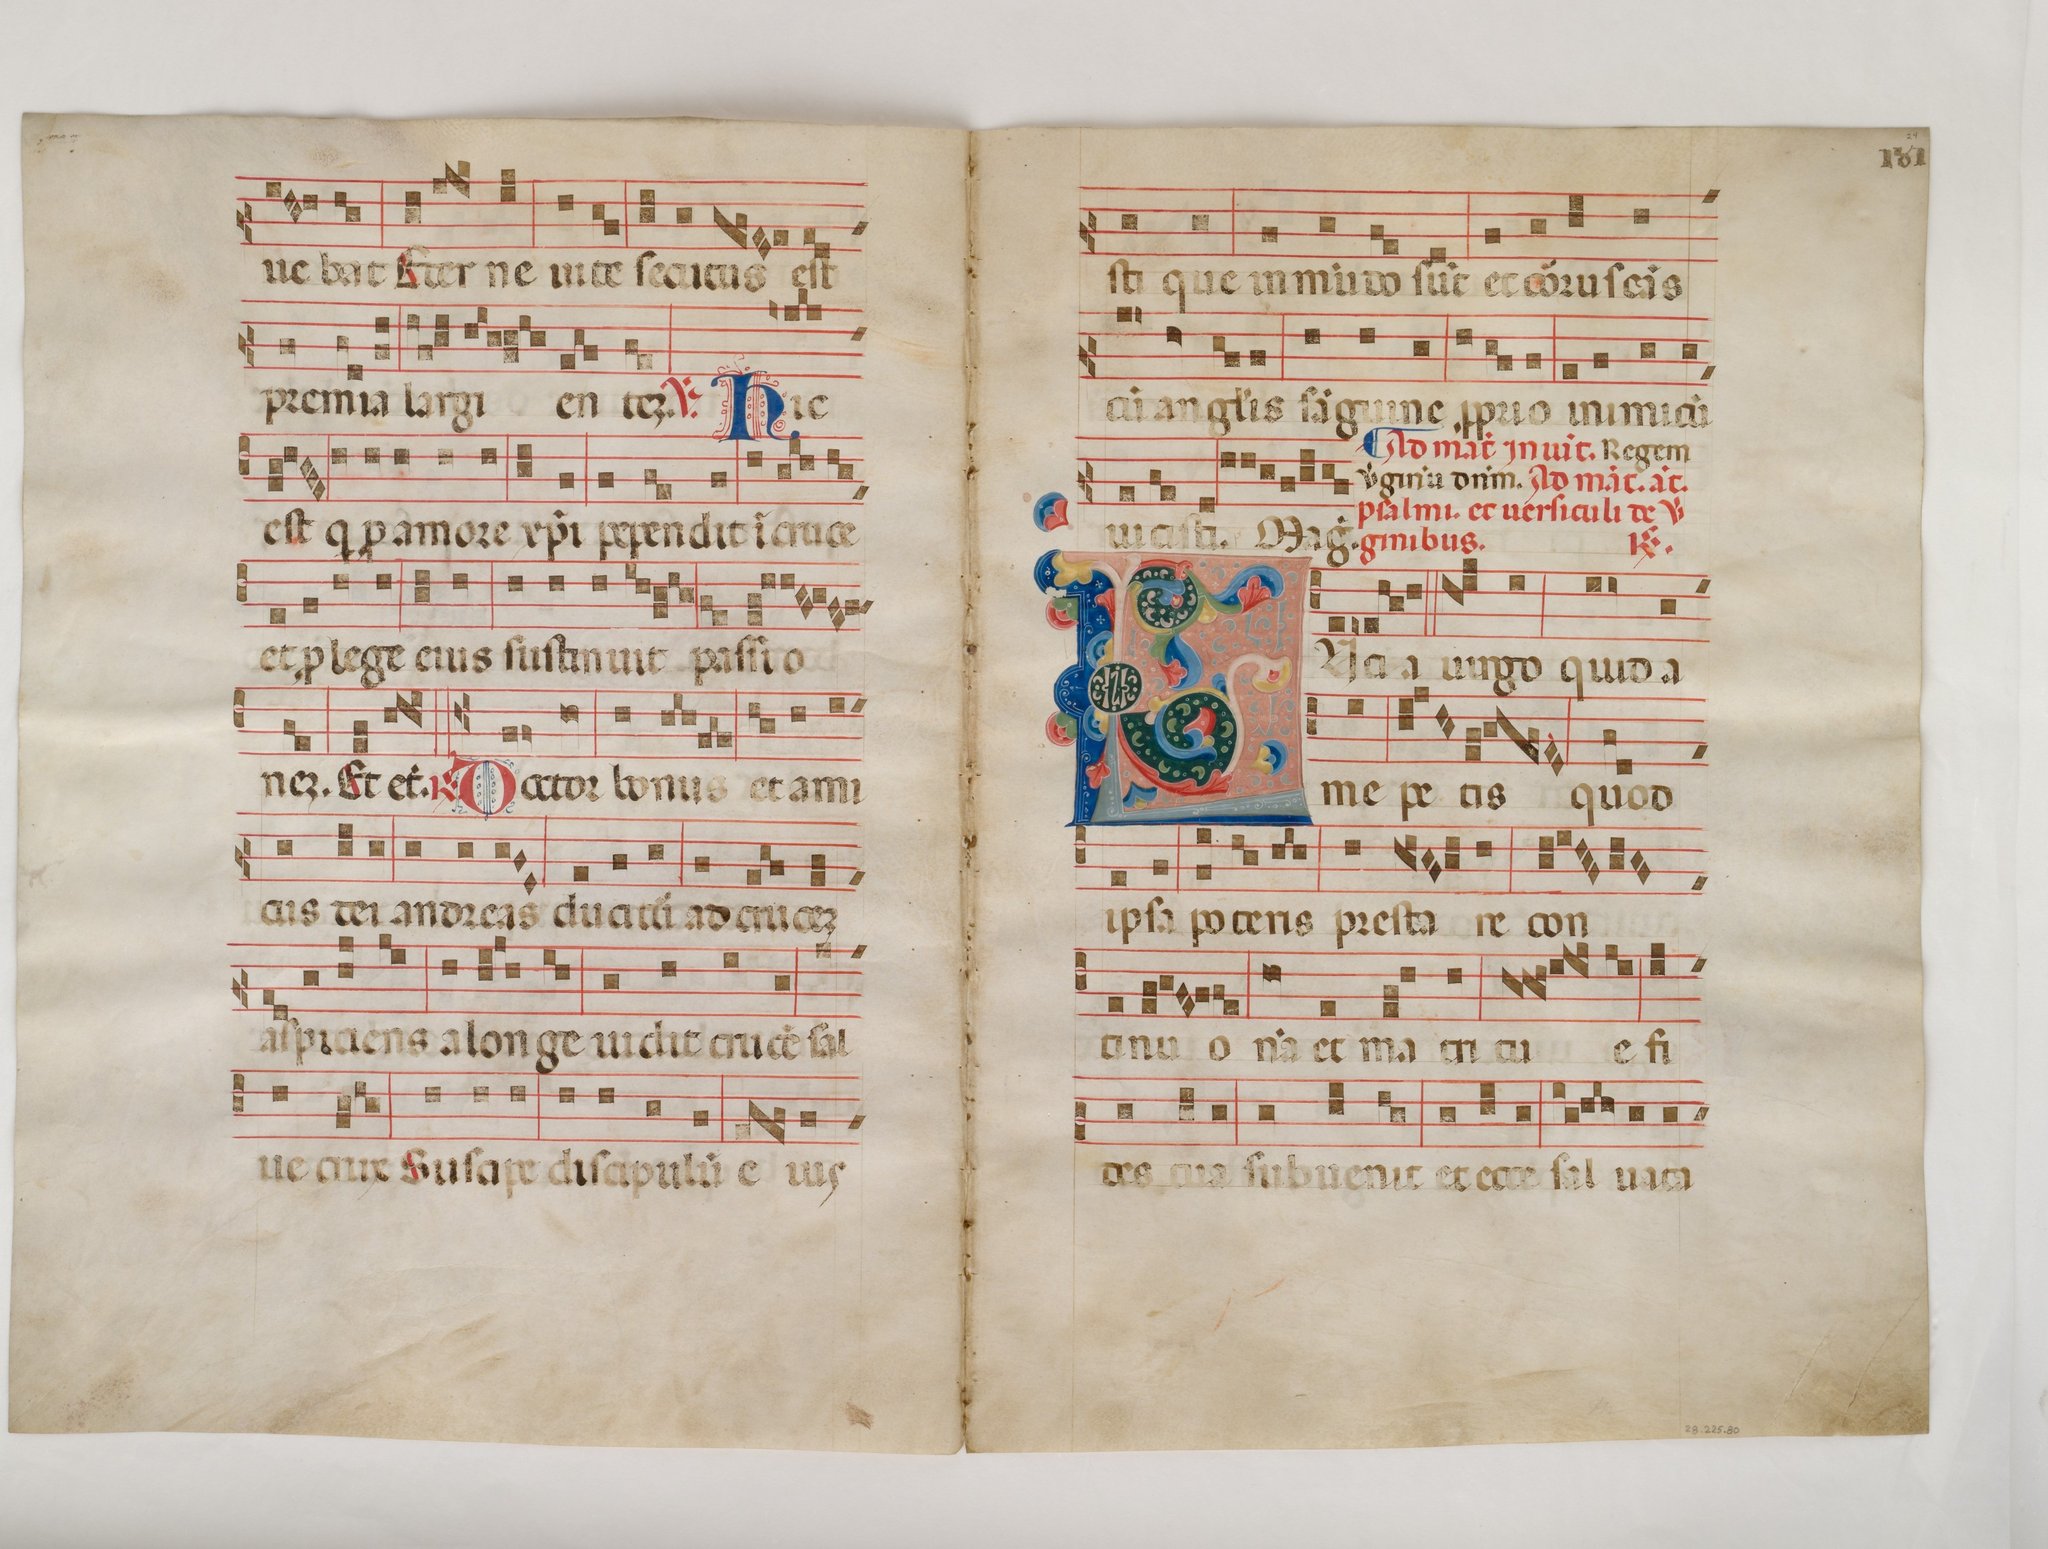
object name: antiphonary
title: Bifolium with Initial L, from an Antiphonary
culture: italian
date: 1301-1400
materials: ink, metal leaf, parchment, paint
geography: italy